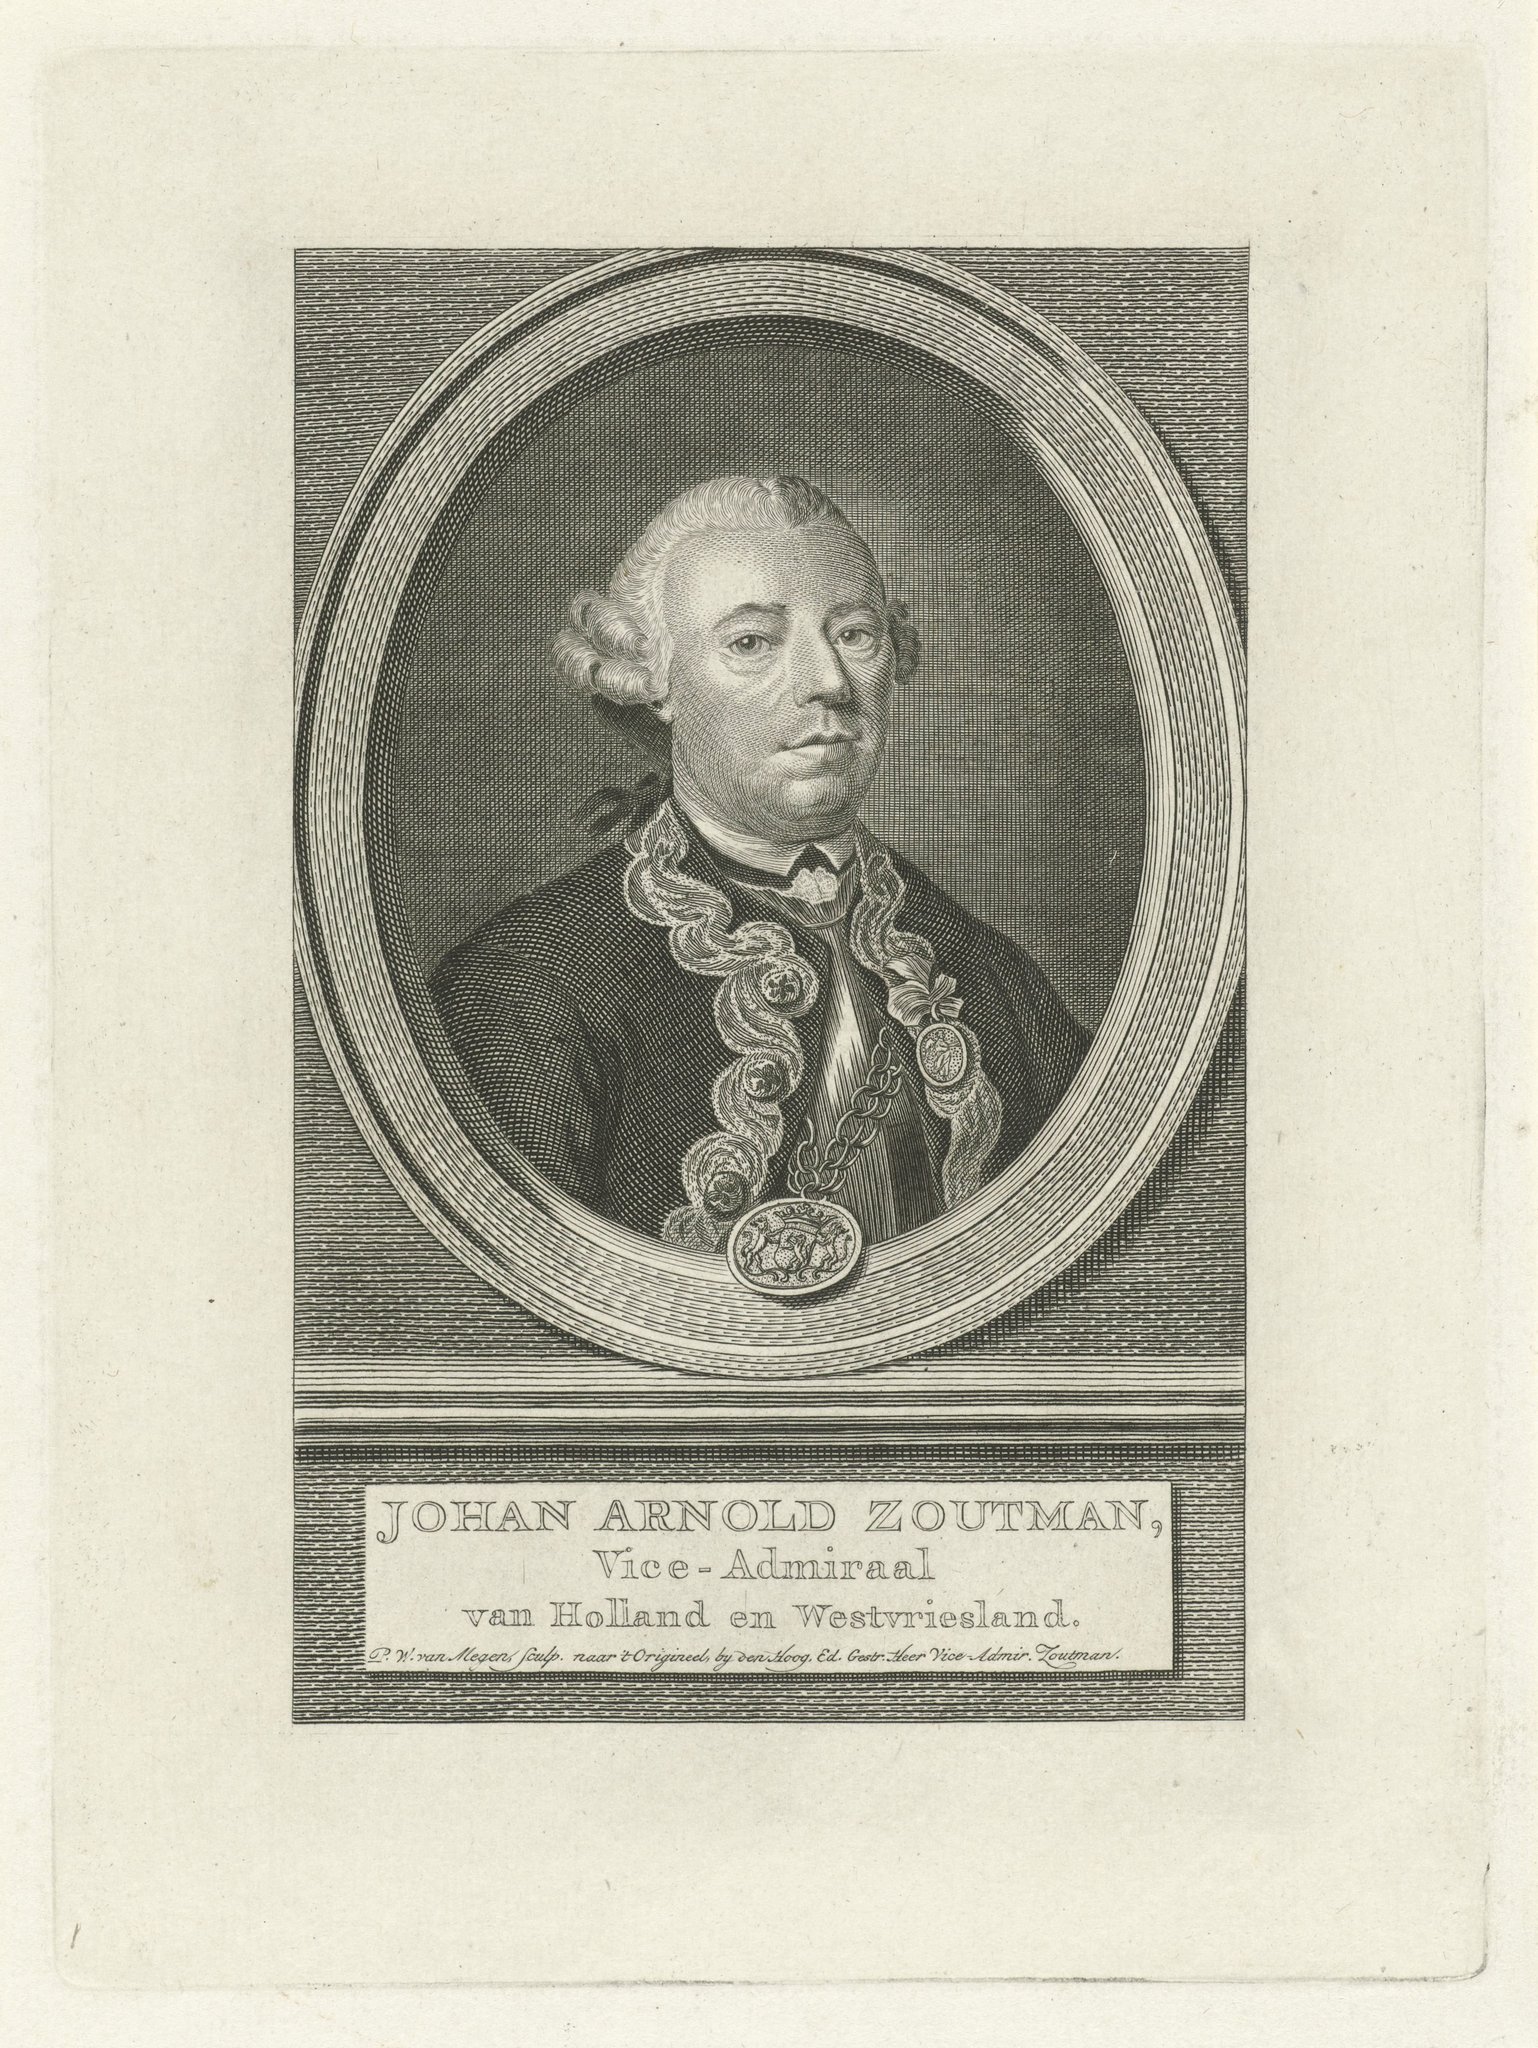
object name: print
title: Portret van Johan Arnold Zoutman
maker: pieter willem van megen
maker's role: print maker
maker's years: 1750-1785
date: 1776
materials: paper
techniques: engraving, etching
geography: the hague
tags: the hague, johan arnold zoutman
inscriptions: collector's mark: Lugt 240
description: Prent waarschijnlijk uit: Nomsz., Johannes. Mengelwerk. Amsterdam: s.n., 1776, dl. 3.